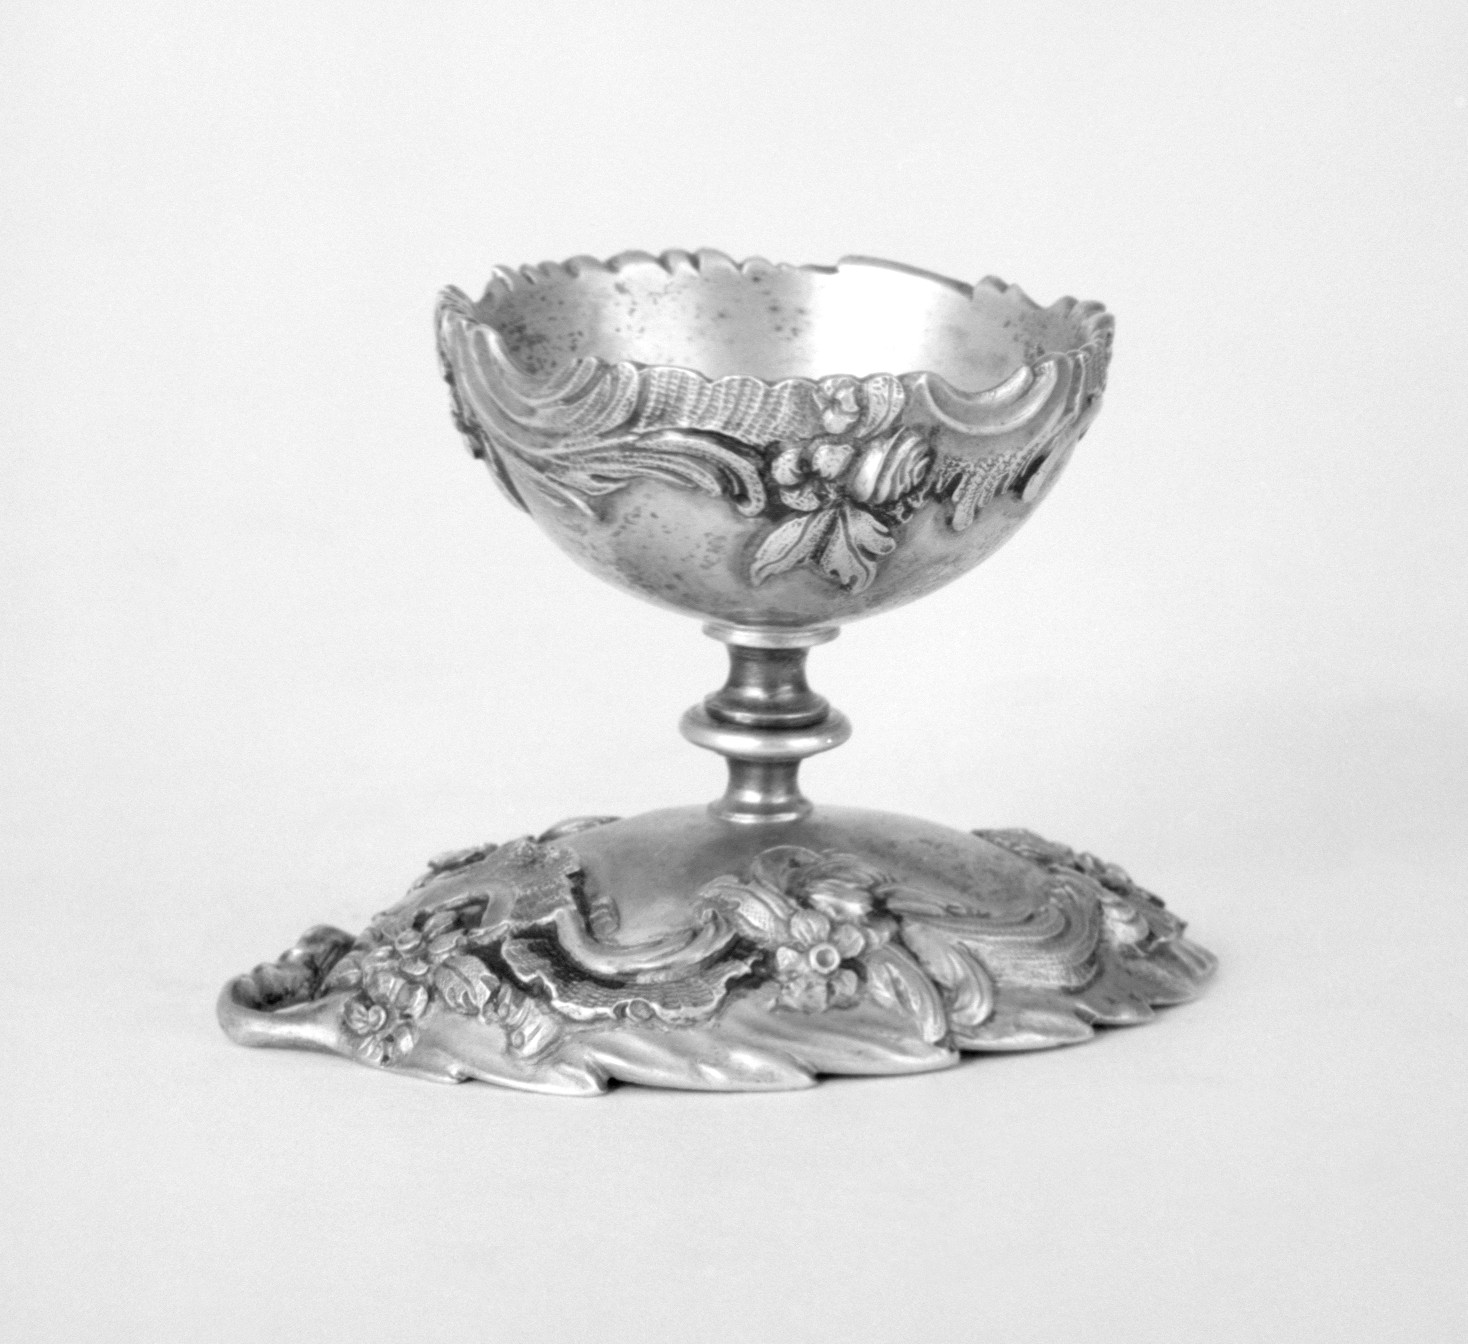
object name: egg cup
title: Reversable egg cup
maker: johann jakob adam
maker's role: maker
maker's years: 1720-1791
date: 1759-1761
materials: silver gilt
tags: flowers